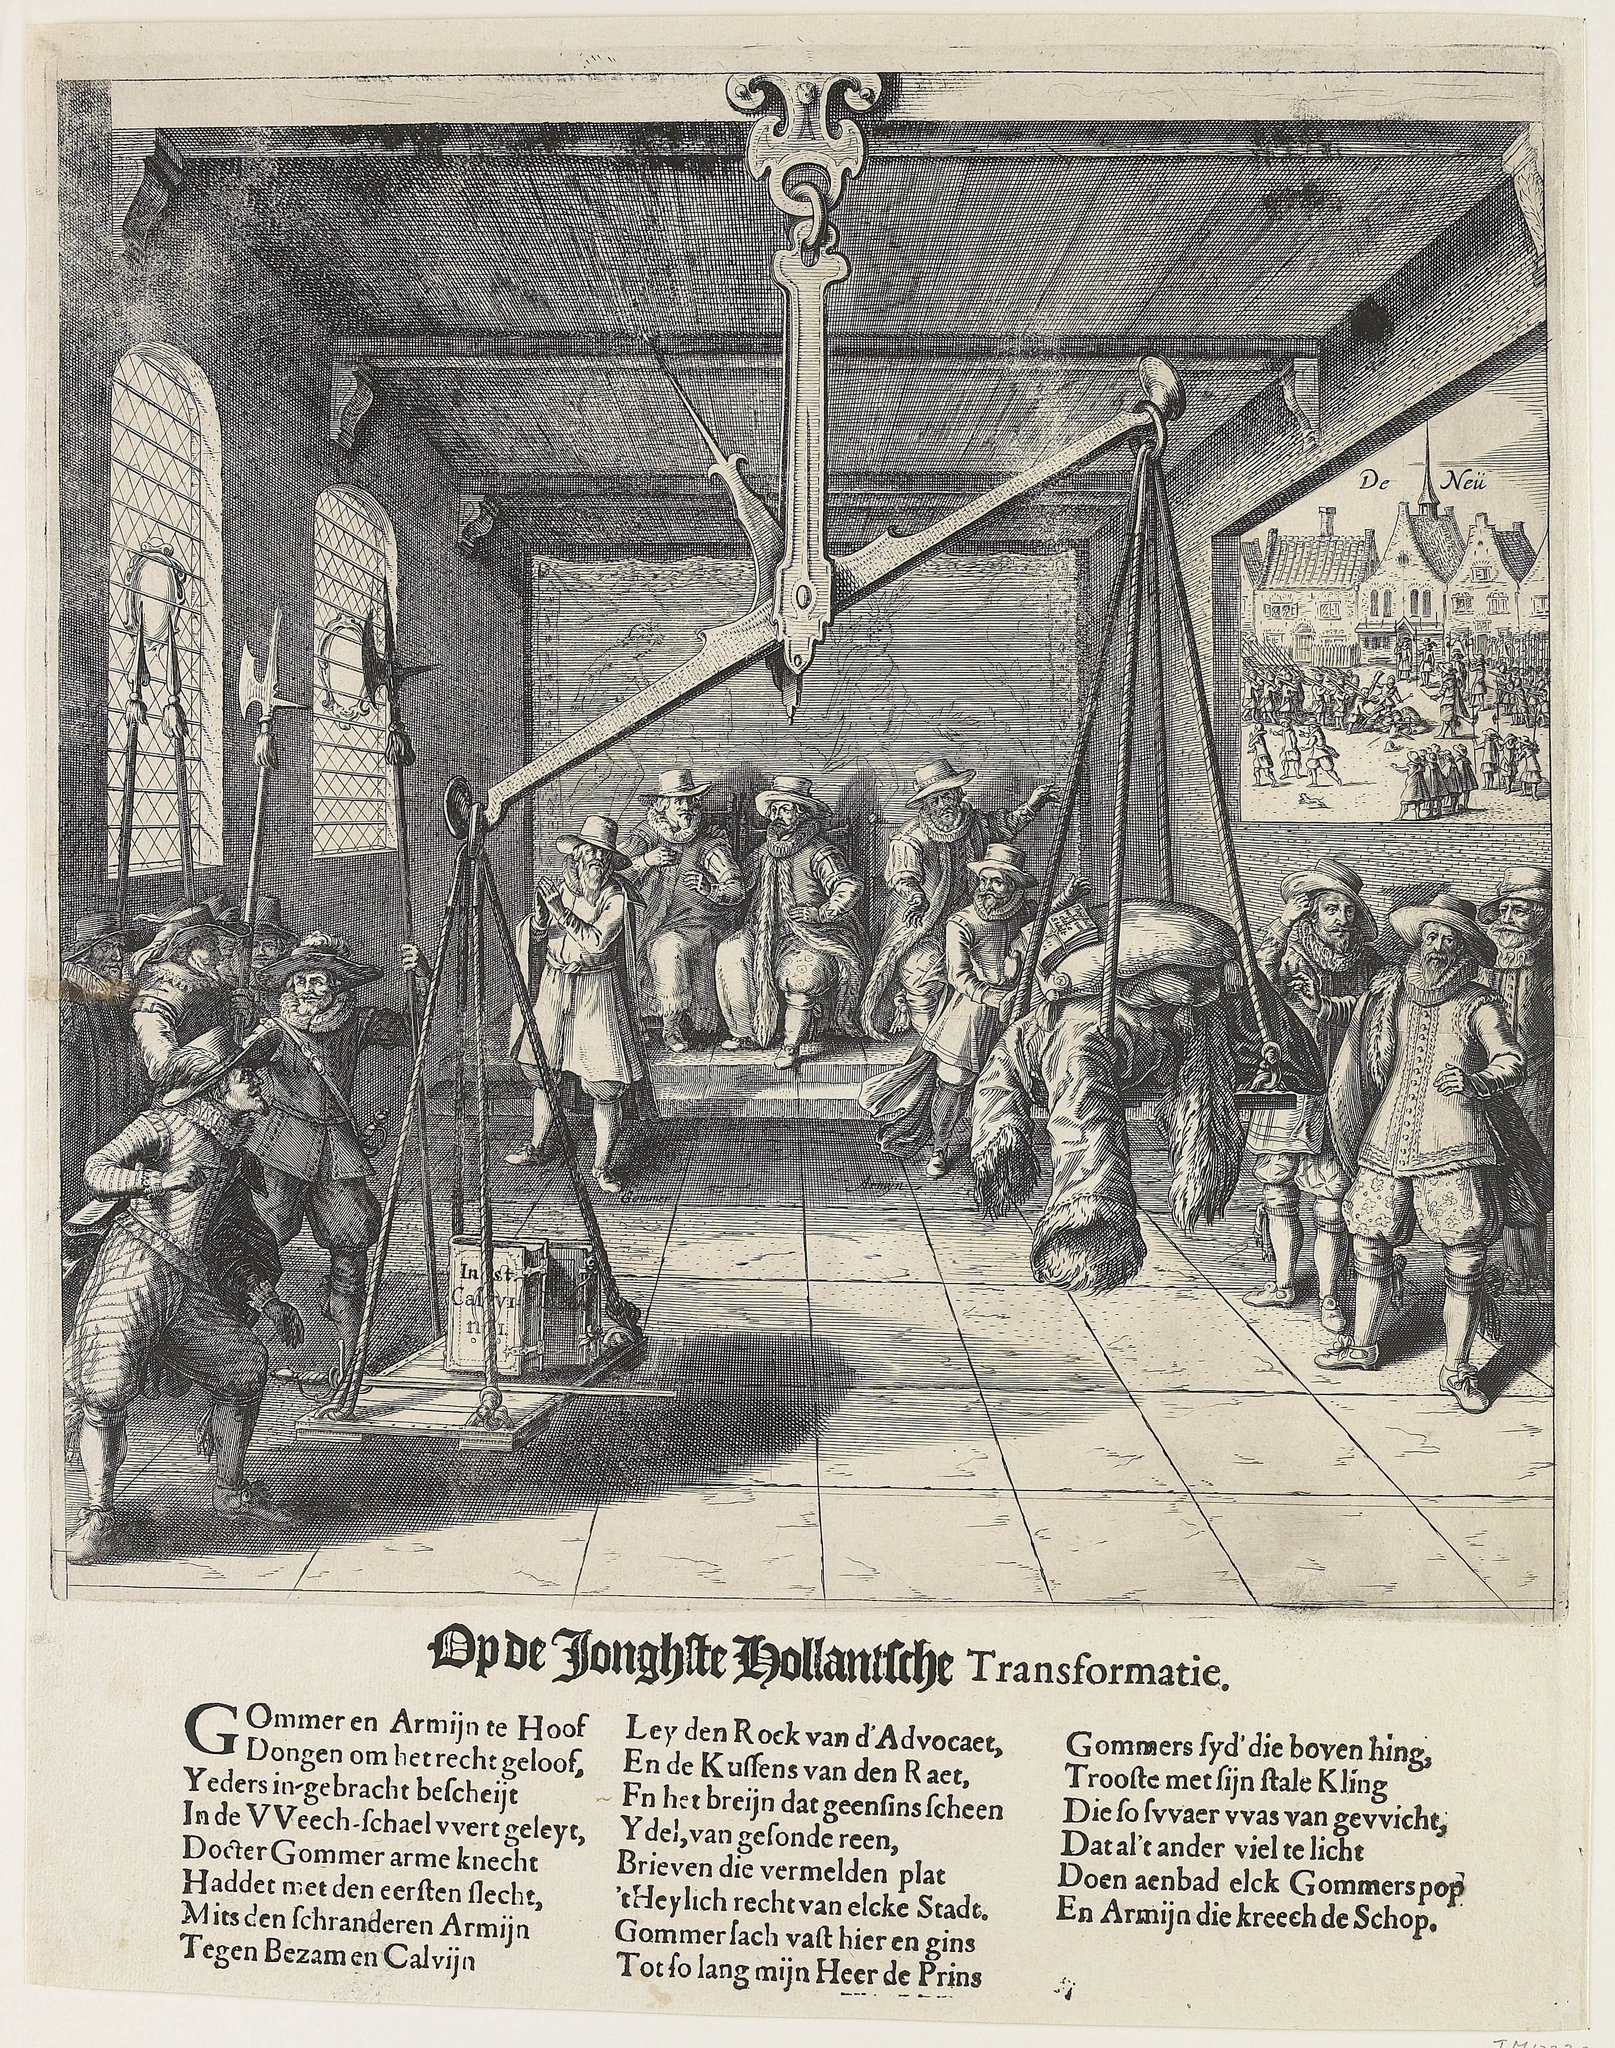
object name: print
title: Op de Jonghste Hollantsche Transformatie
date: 1618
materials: paper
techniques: engraving, letterpress printing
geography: northern netherlands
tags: johan van oldenbarnevelt, the hague, maurice (prince of orange), leiden, bruges, scales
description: Politieke allegorie op de overwinning van de contraremonstranten dankzij het ingrijpen van prins Maurits, 1618. De voorstelling toont een interieur met een grote weegschaal. Hierop worden, in aanwezigheid van Gomarus, Arminius, Johan van Oldenbarnevelt en anderen, de argumenten van de contraremonstranten en de remonstranten tegen elkaar afgewogen. Maurits doet de balans ten gunste van de contraremonstranten doorslaan door zijn zwaard op de weegschaal te leggen. Op de achtergrond door een venster de afdanking van de waardgelders door Maurits op de Neude te Utrecht. Onder de voorstelling in drie kolommen een vers van Vondel.